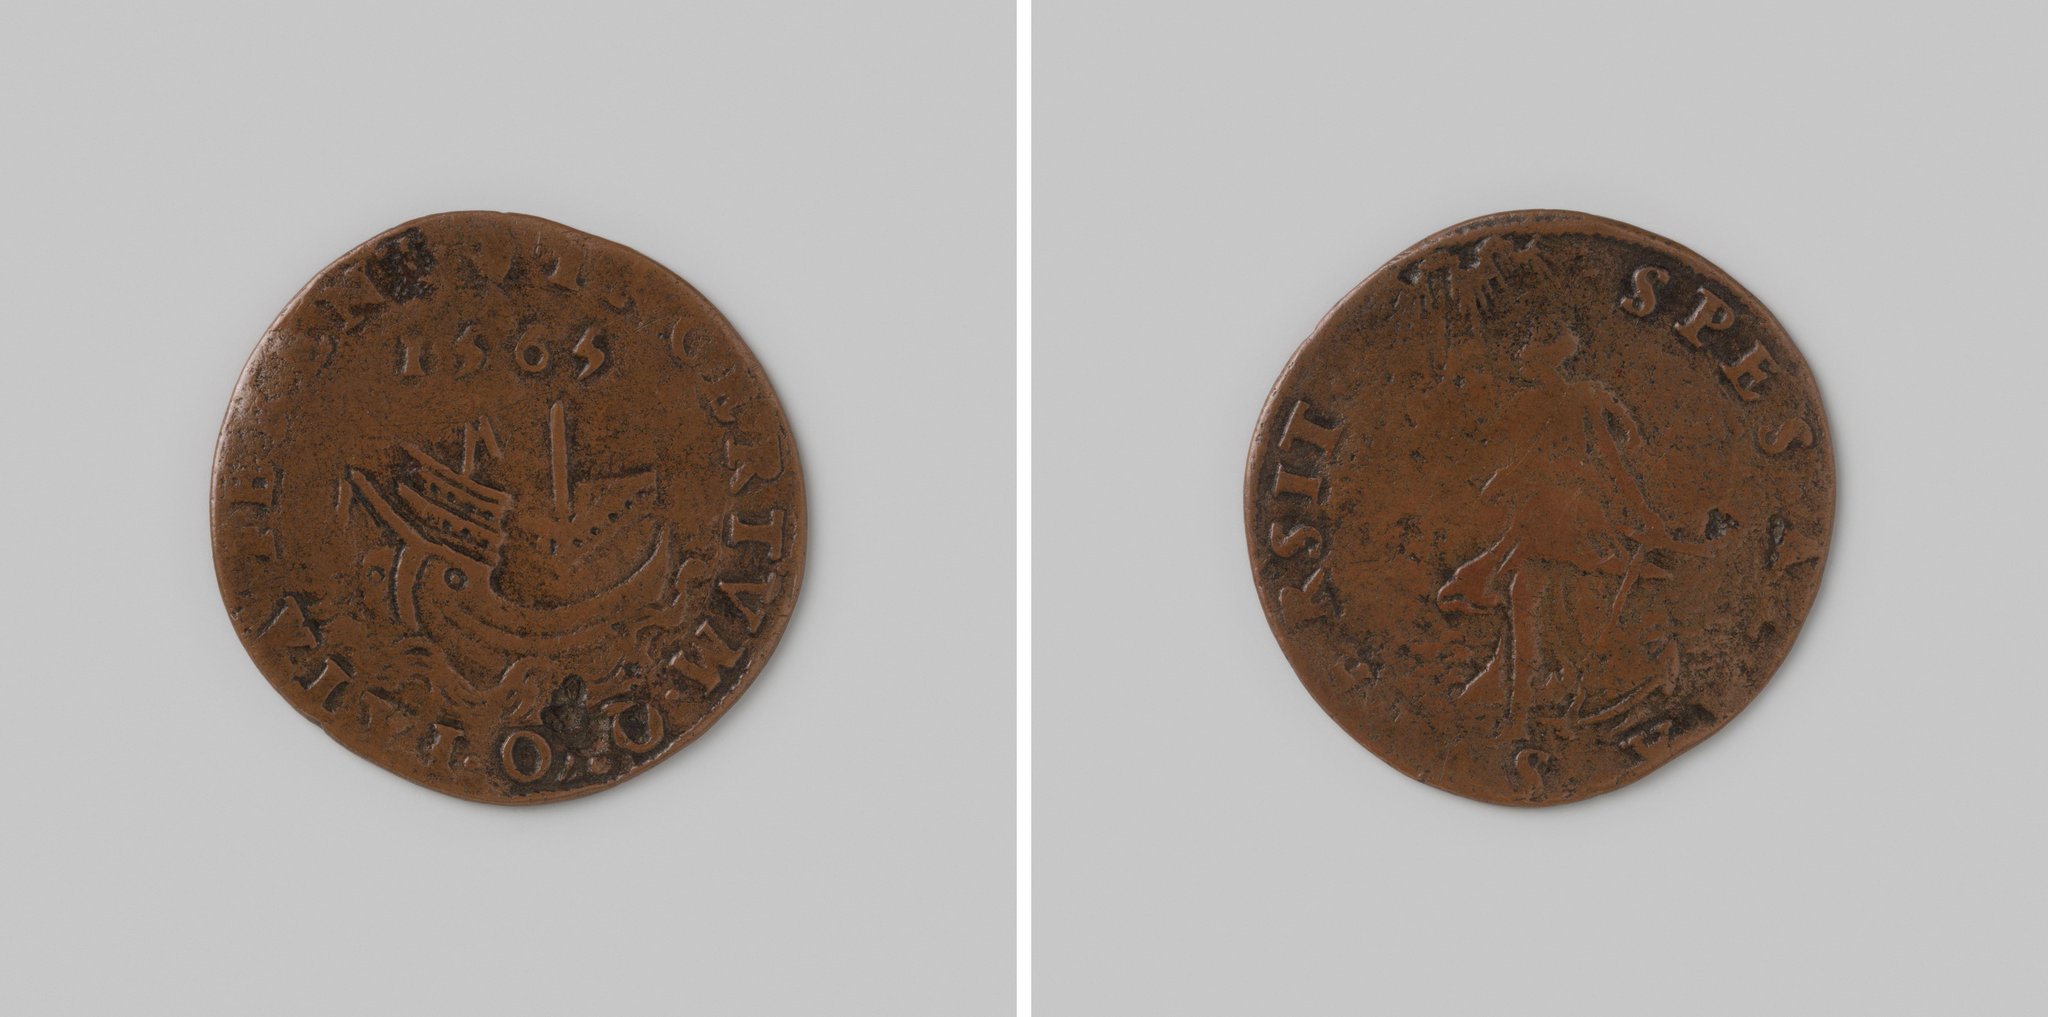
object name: history medal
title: Rekenpenning uit Antwerpen op de naderende storm in Nederland 1565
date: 1565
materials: copper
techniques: striking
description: Koperen penning, op de voorzijde een stuurloos zeilschip met afgebroken mast, met omschrift, op de keerzijde de Hoop omhoog wijzend naar de naam Gods, met omschrift.